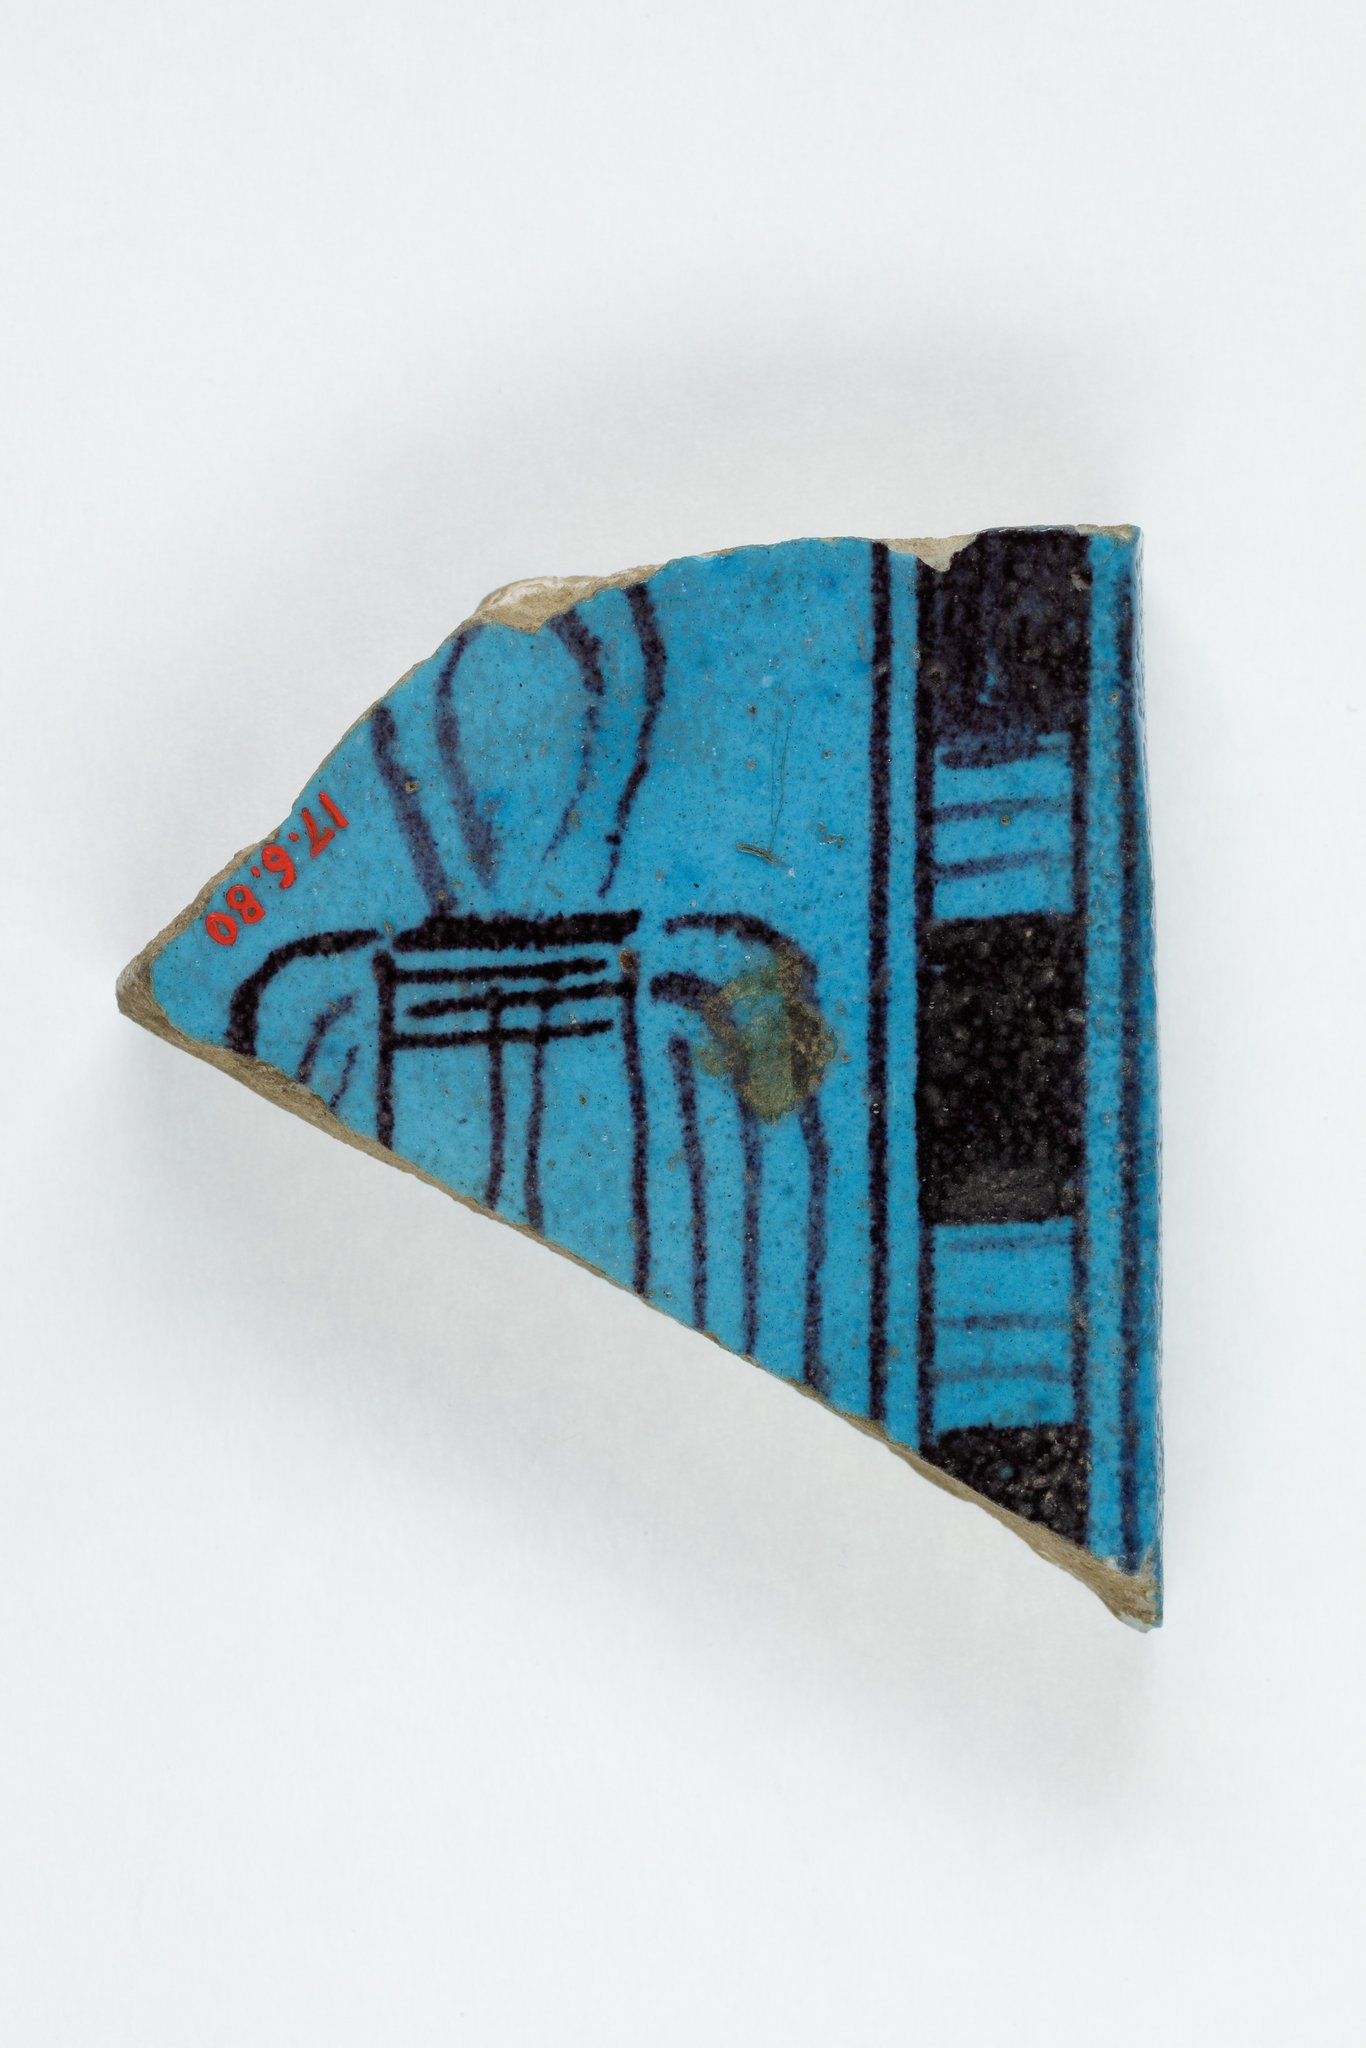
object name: tile fragment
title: Fragmentary Tile from a Foundation Deposit (?)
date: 1550-1295 BCE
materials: faience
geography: northern upper egypt